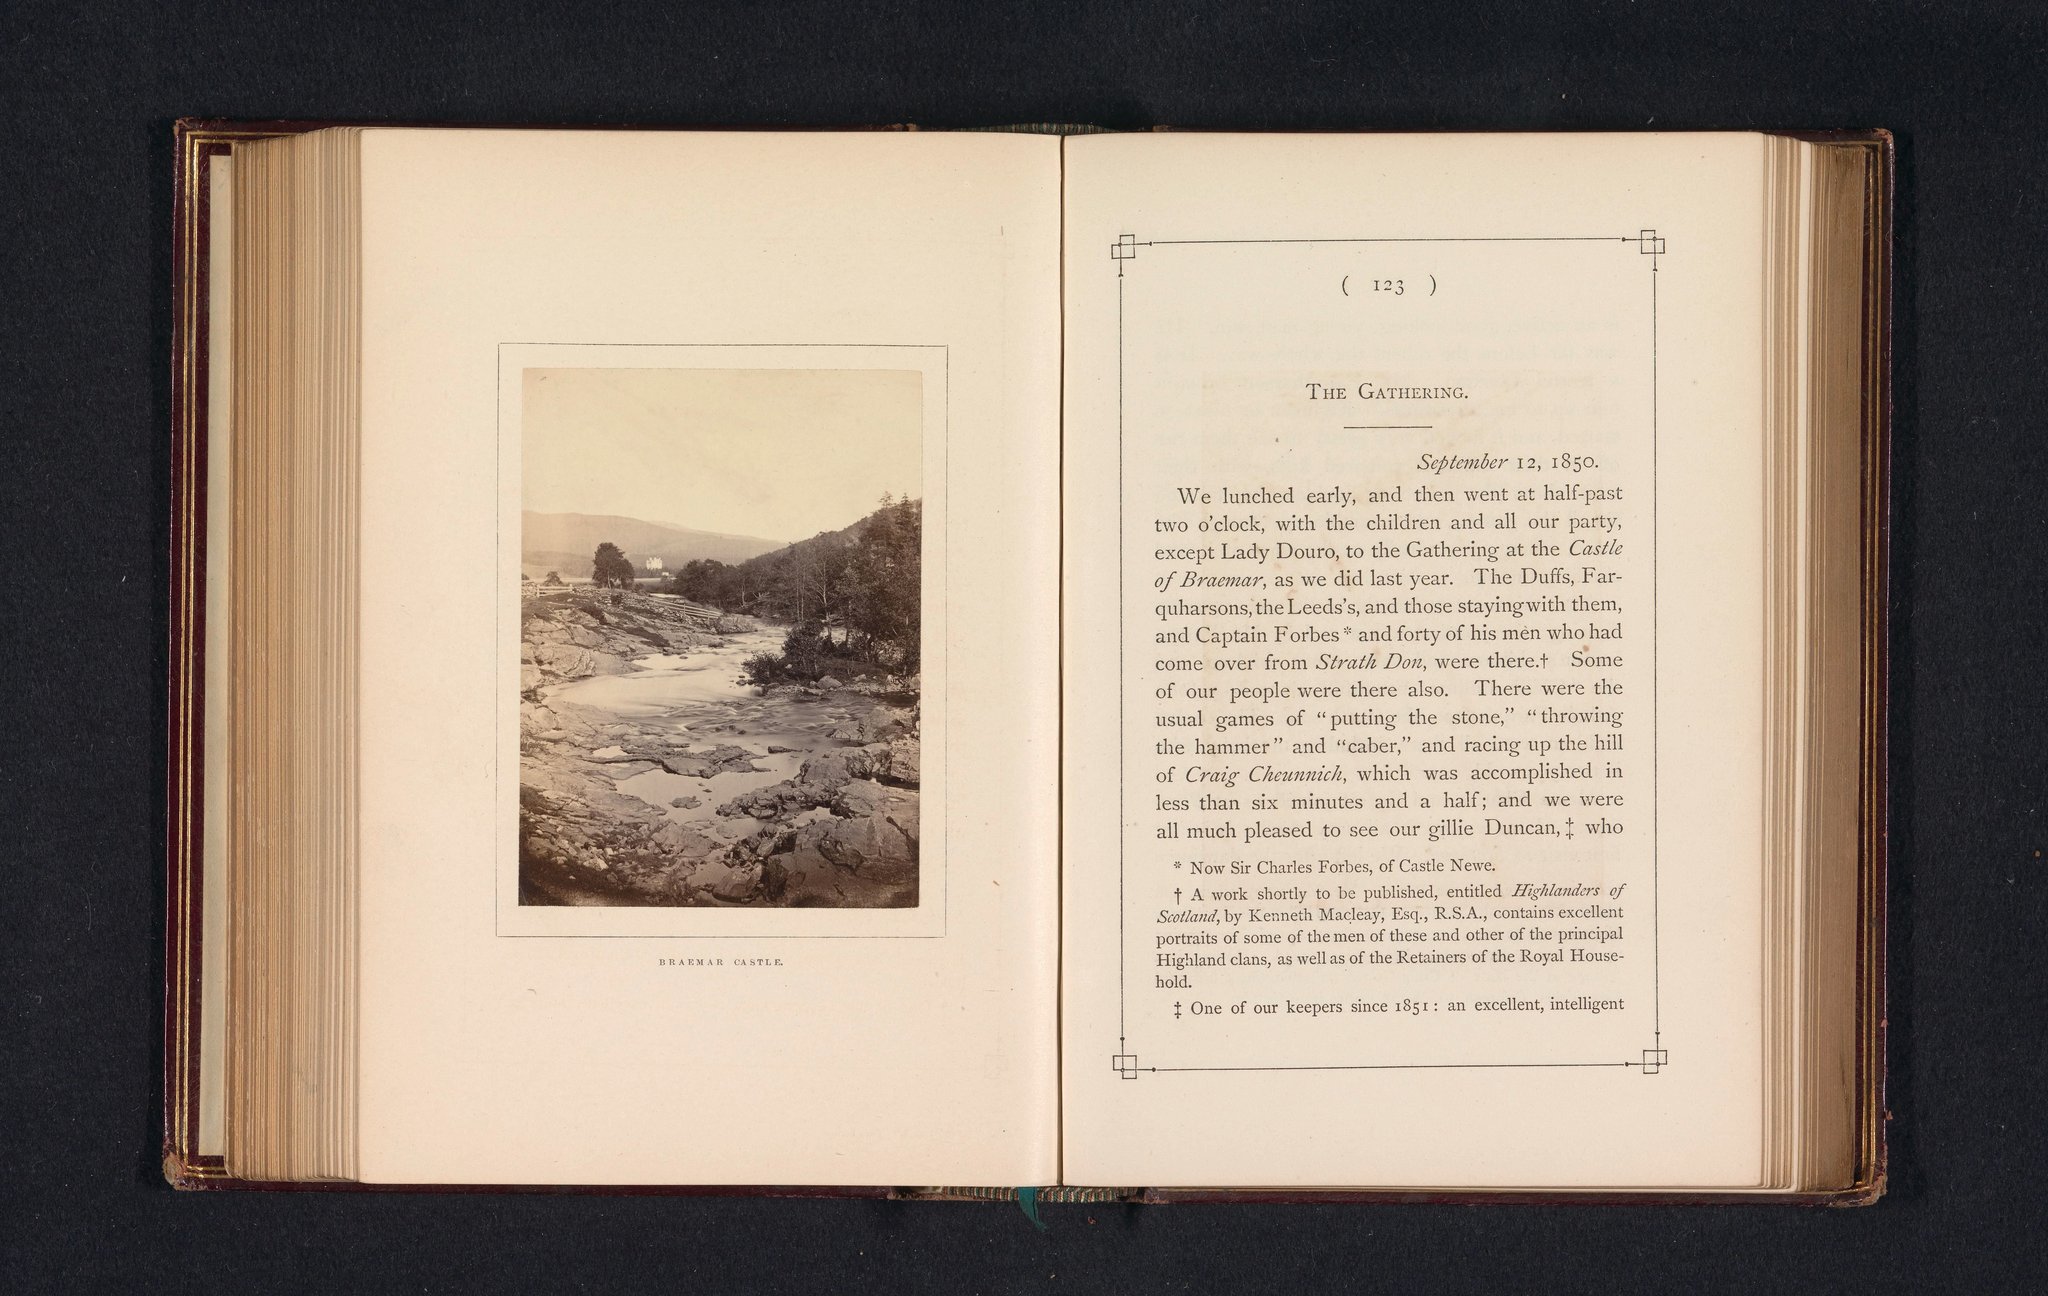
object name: page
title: Braemar Castle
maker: george washington wilson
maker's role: publisher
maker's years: 1823-1893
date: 1858-1868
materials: photographic support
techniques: albumen print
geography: aberdeenshire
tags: castle, river